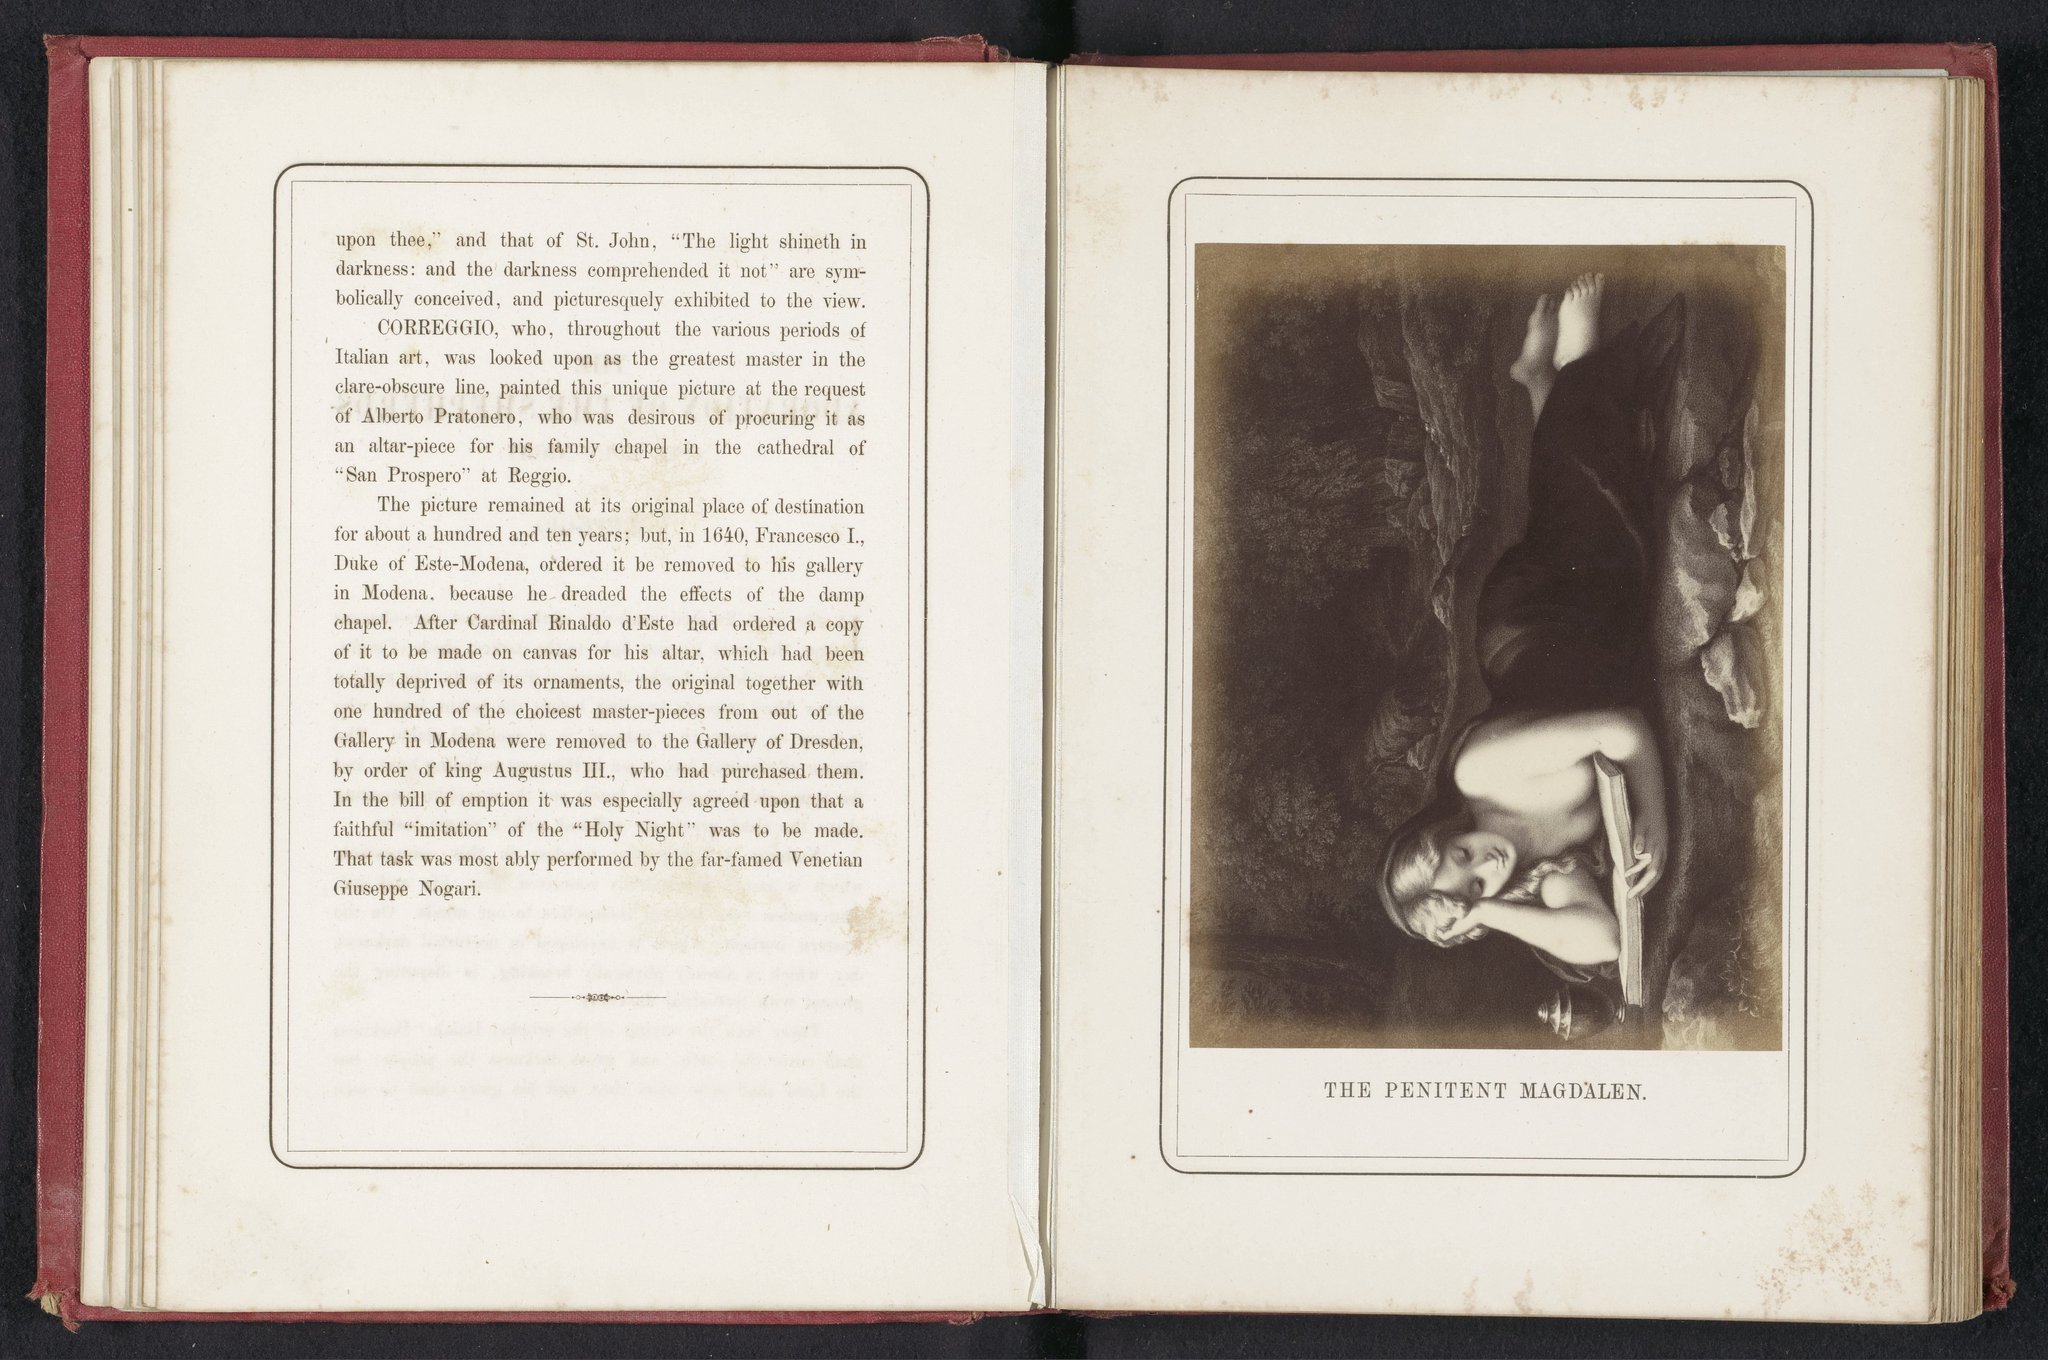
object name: reproduction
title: The Penitent Magdalen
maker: hanns hanfstaengl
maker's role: print maker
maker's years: 1820-1885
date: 1854-1864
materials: photographic support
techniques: albumen print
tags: picture, painting, the penitent harlot mary magdalene; possible attributes: book (or scroll), crown, crown of thorns, crucifix, jar of ointment, mirror, musical instrument, palm-branch, rosary, scourge